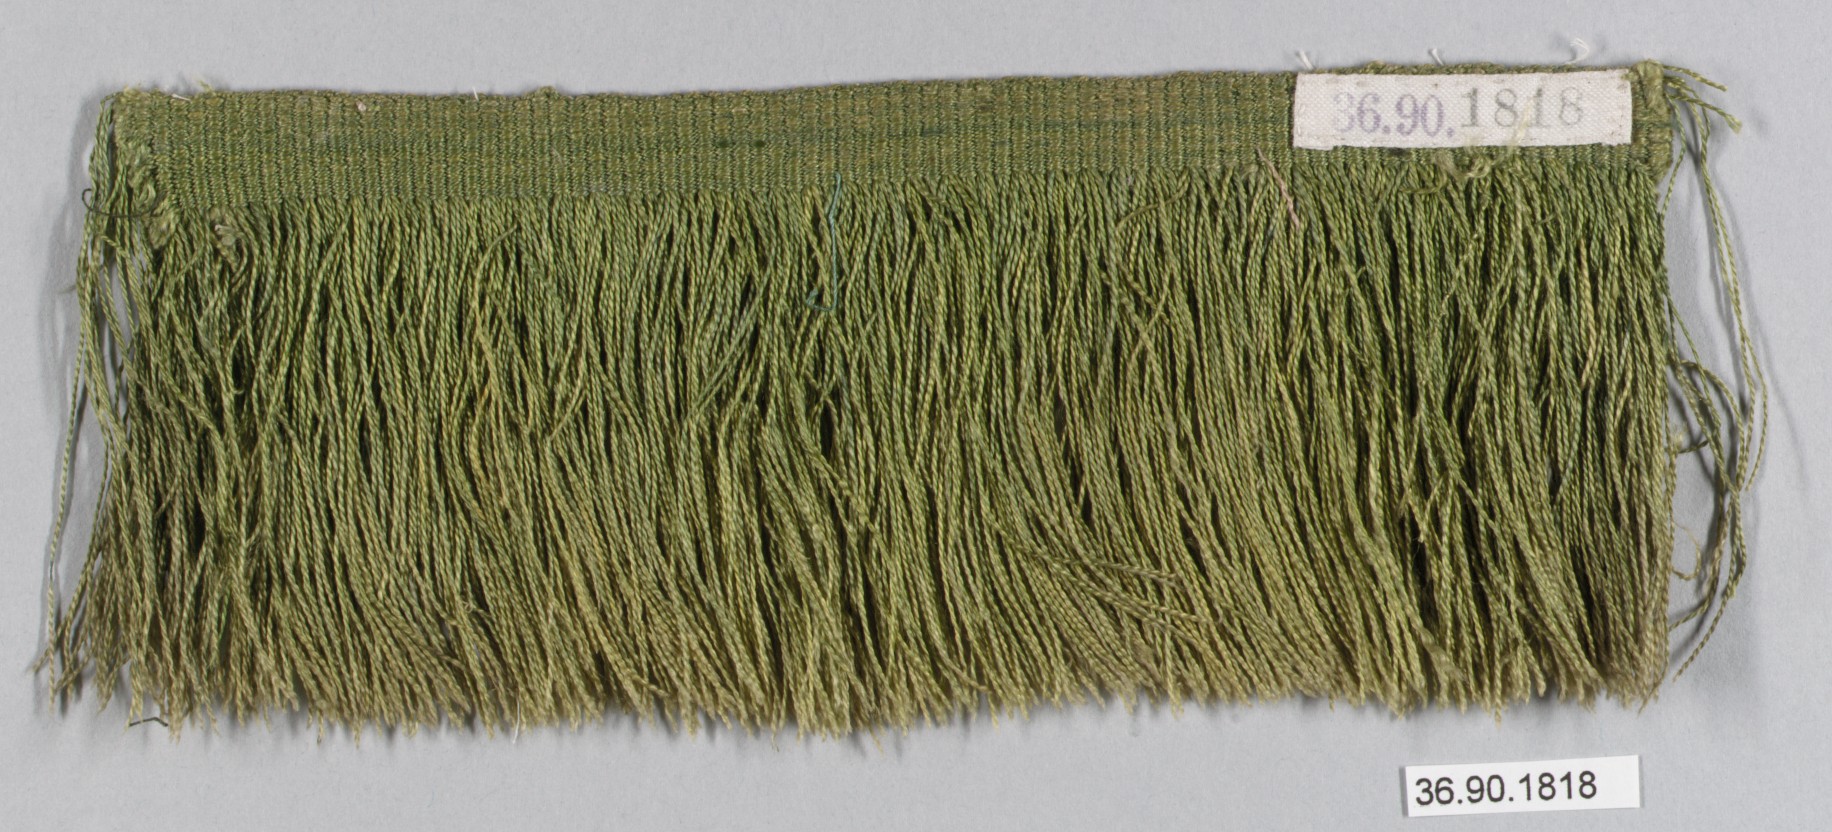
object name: fringe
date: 1734-1766